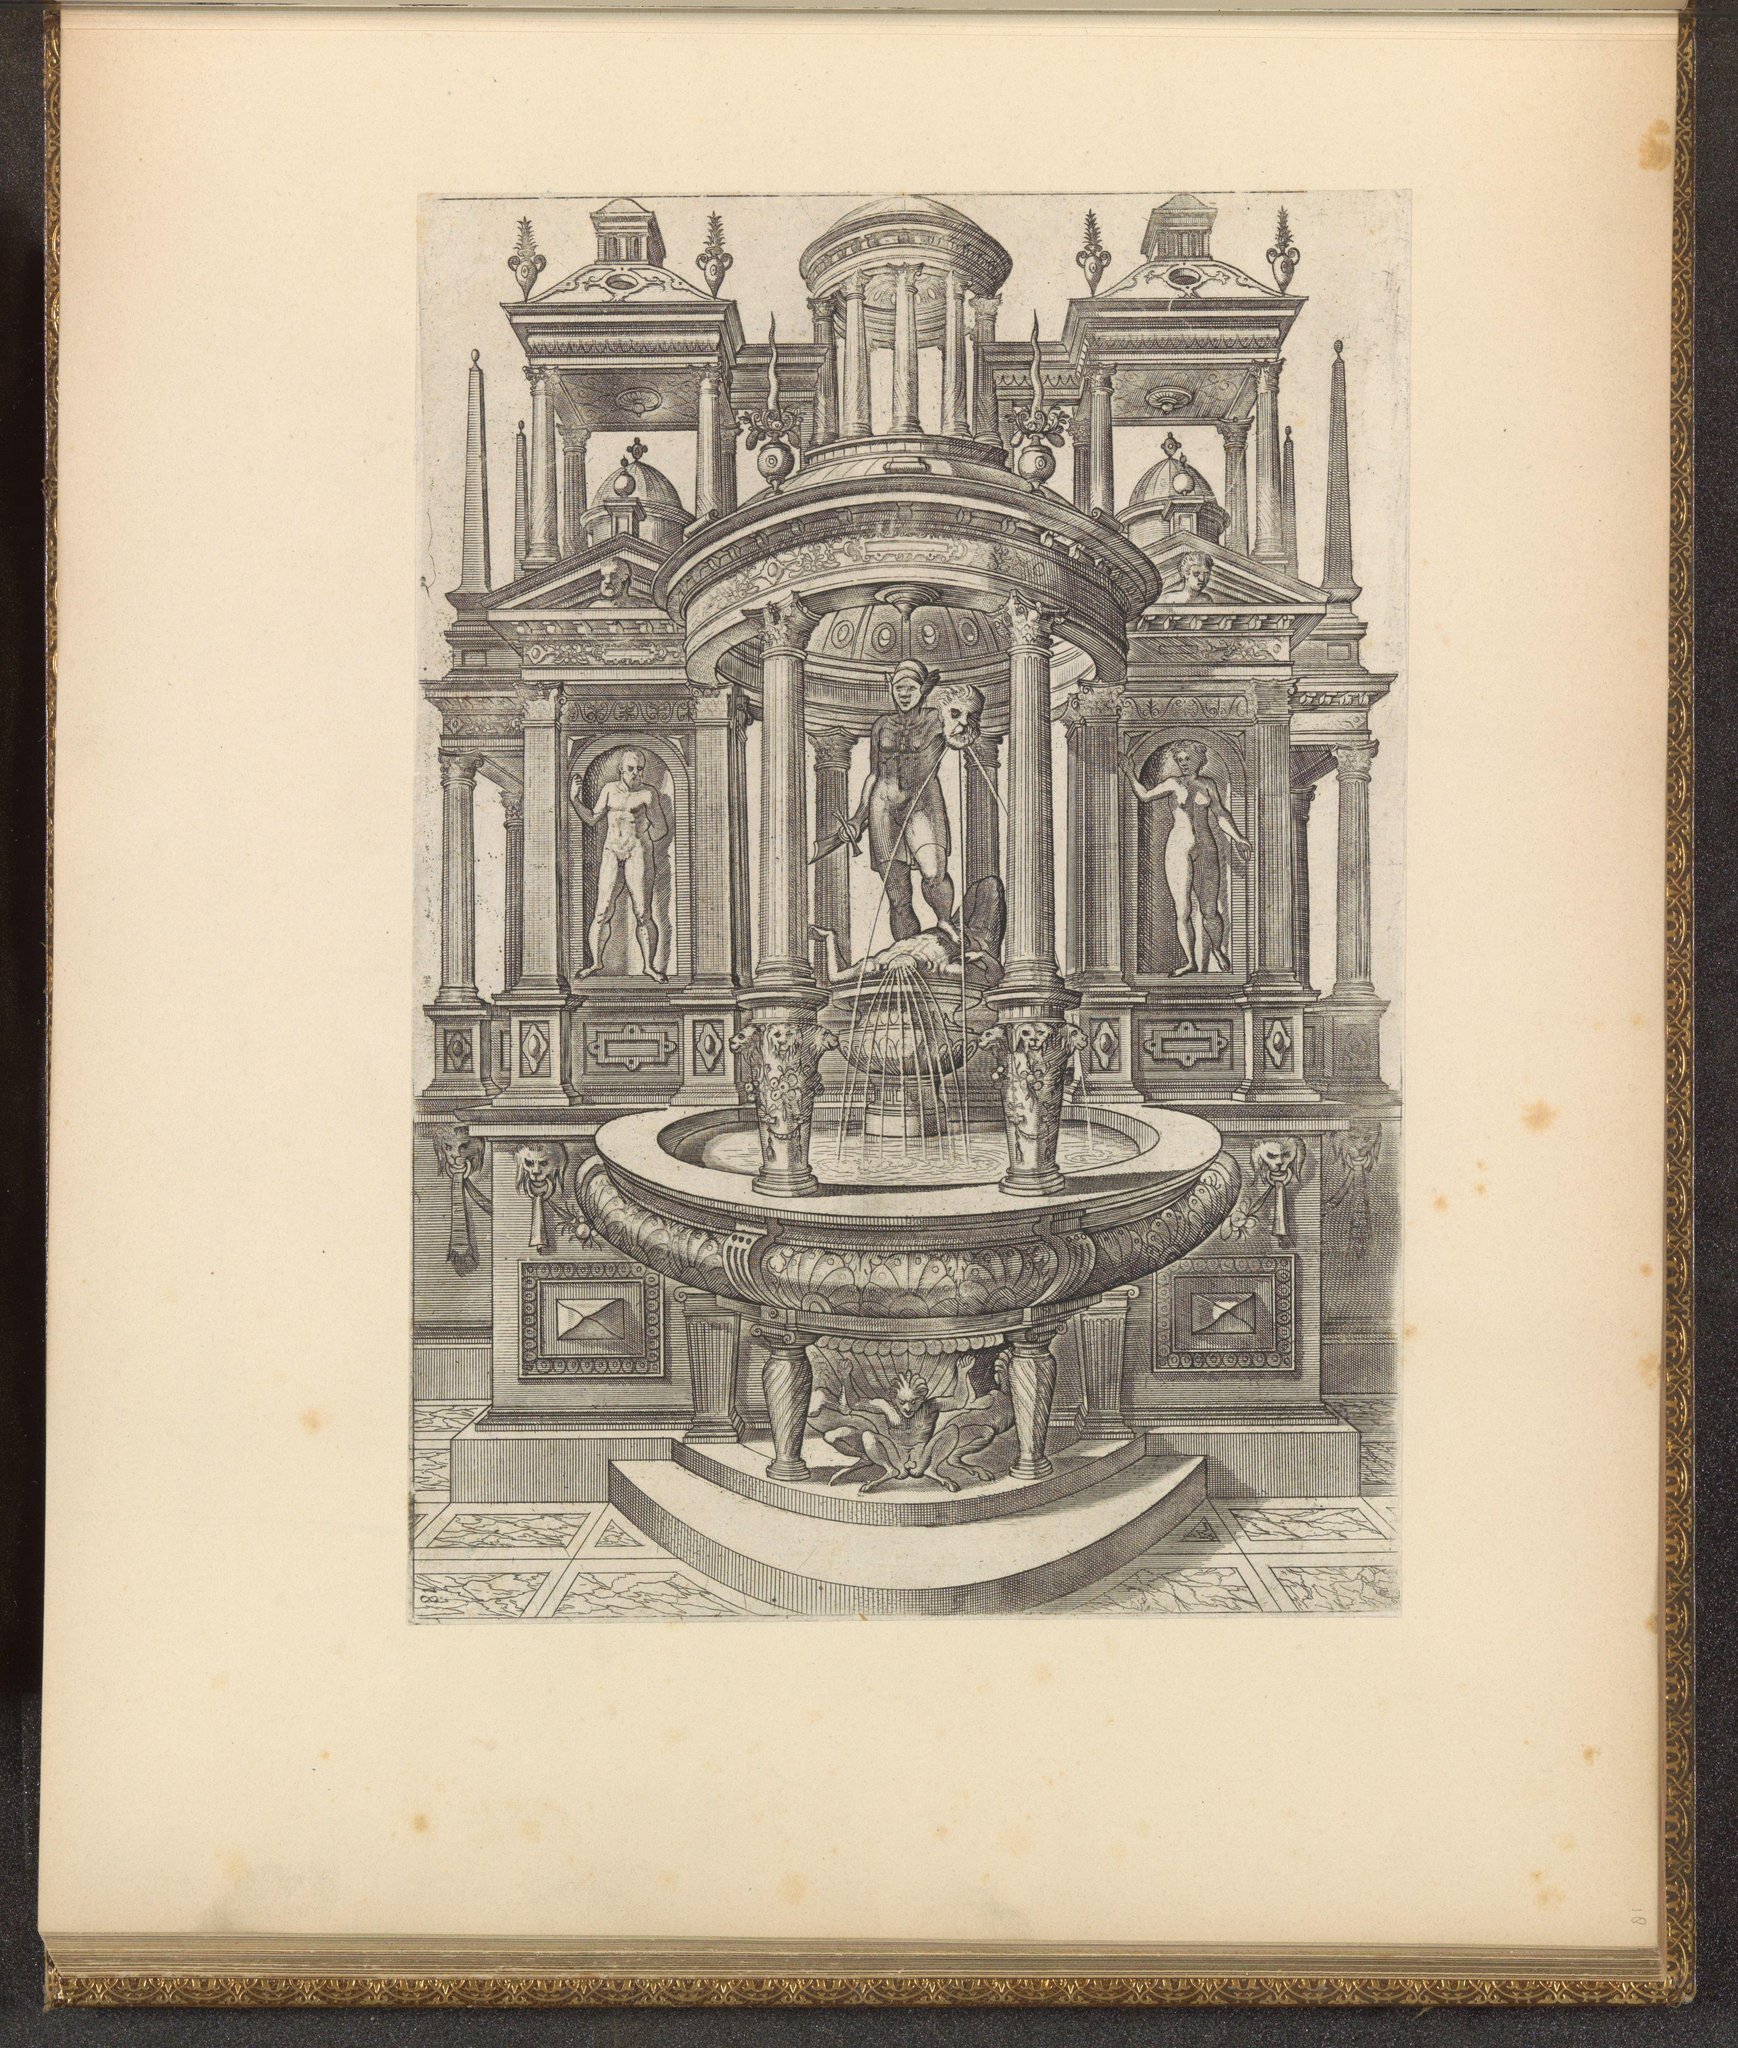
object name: album leaf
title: Ronde fontein met een beeld van David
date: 1600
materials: paper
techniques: etching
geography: antwerp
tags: david with goliath's head, ornamental fountain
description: Vrijstaande monumentale fontein met een rijke orde-architectuur. Hiervoor ligt een rond uitgebouwd bekken onder een ronde koepel. In het bekken staat op een voetstuk David met het hoofd van Goliat. De prent maakt deel uit van een album.